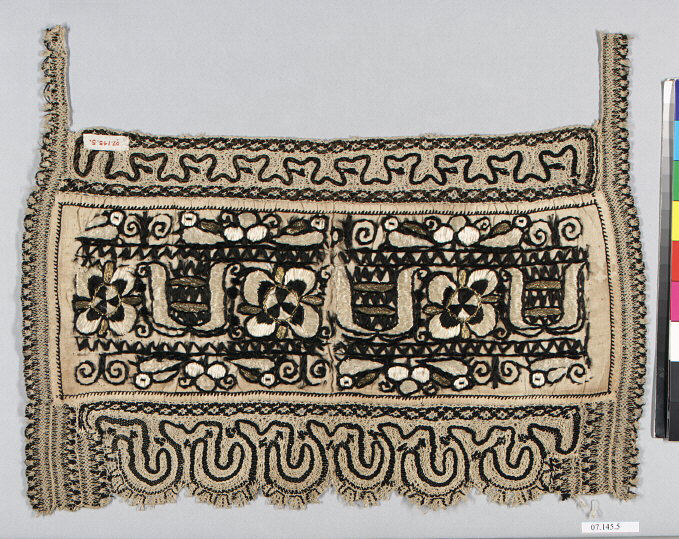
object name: cuff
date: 1801-1900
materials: thread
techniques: lace